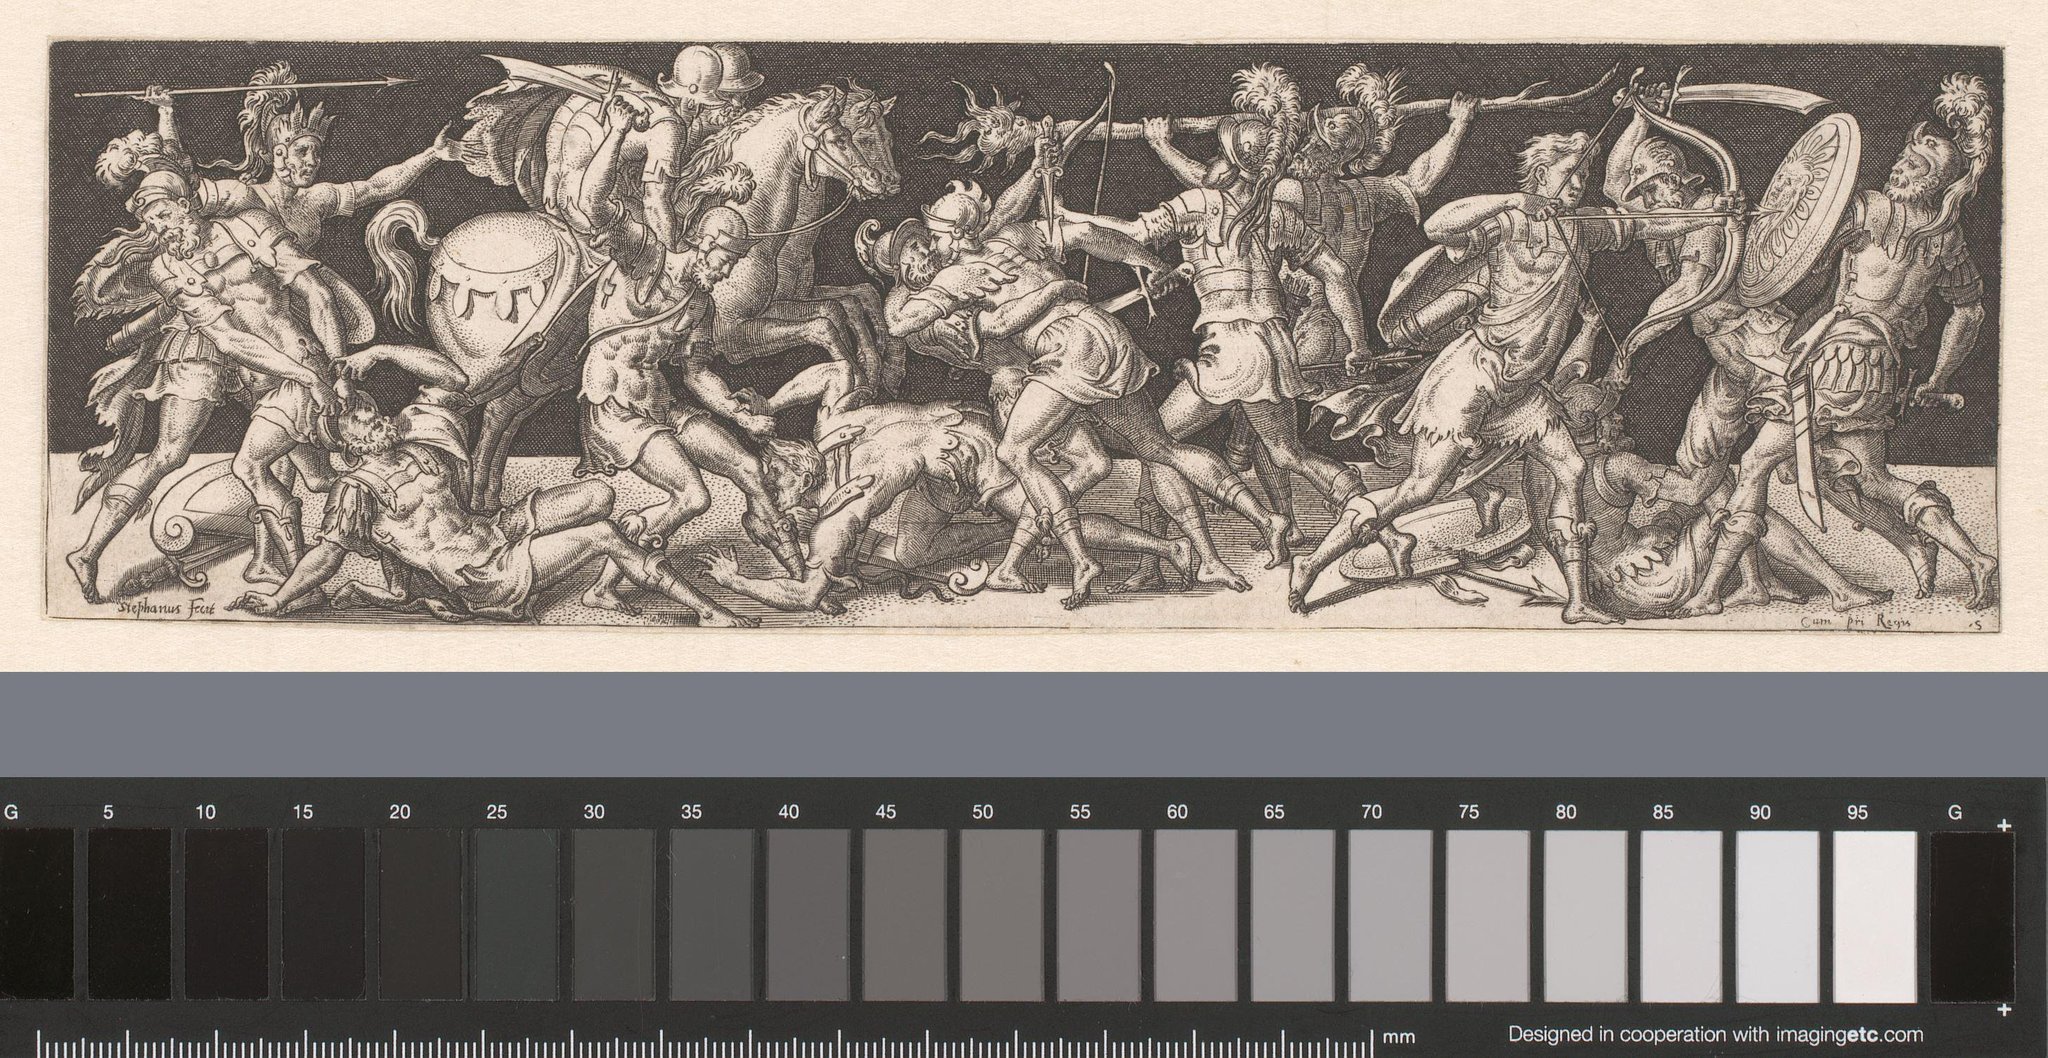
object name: print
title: Gevecht tussen cavaleristen en infanteristen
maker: etienne delaune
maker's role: draughtsman, goldsmith, print maker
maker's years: 1519-1583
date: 1528-1583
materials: paper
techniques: engraving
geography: france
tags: battle, military discipline (+ cavalry, horsemen), military discipline (+ infantry)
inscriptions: collector's mark: Lugt 240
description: Maakt deel uit van een twaalfdelige serie met gevechten en optochten tegen een donkere achtergrond.